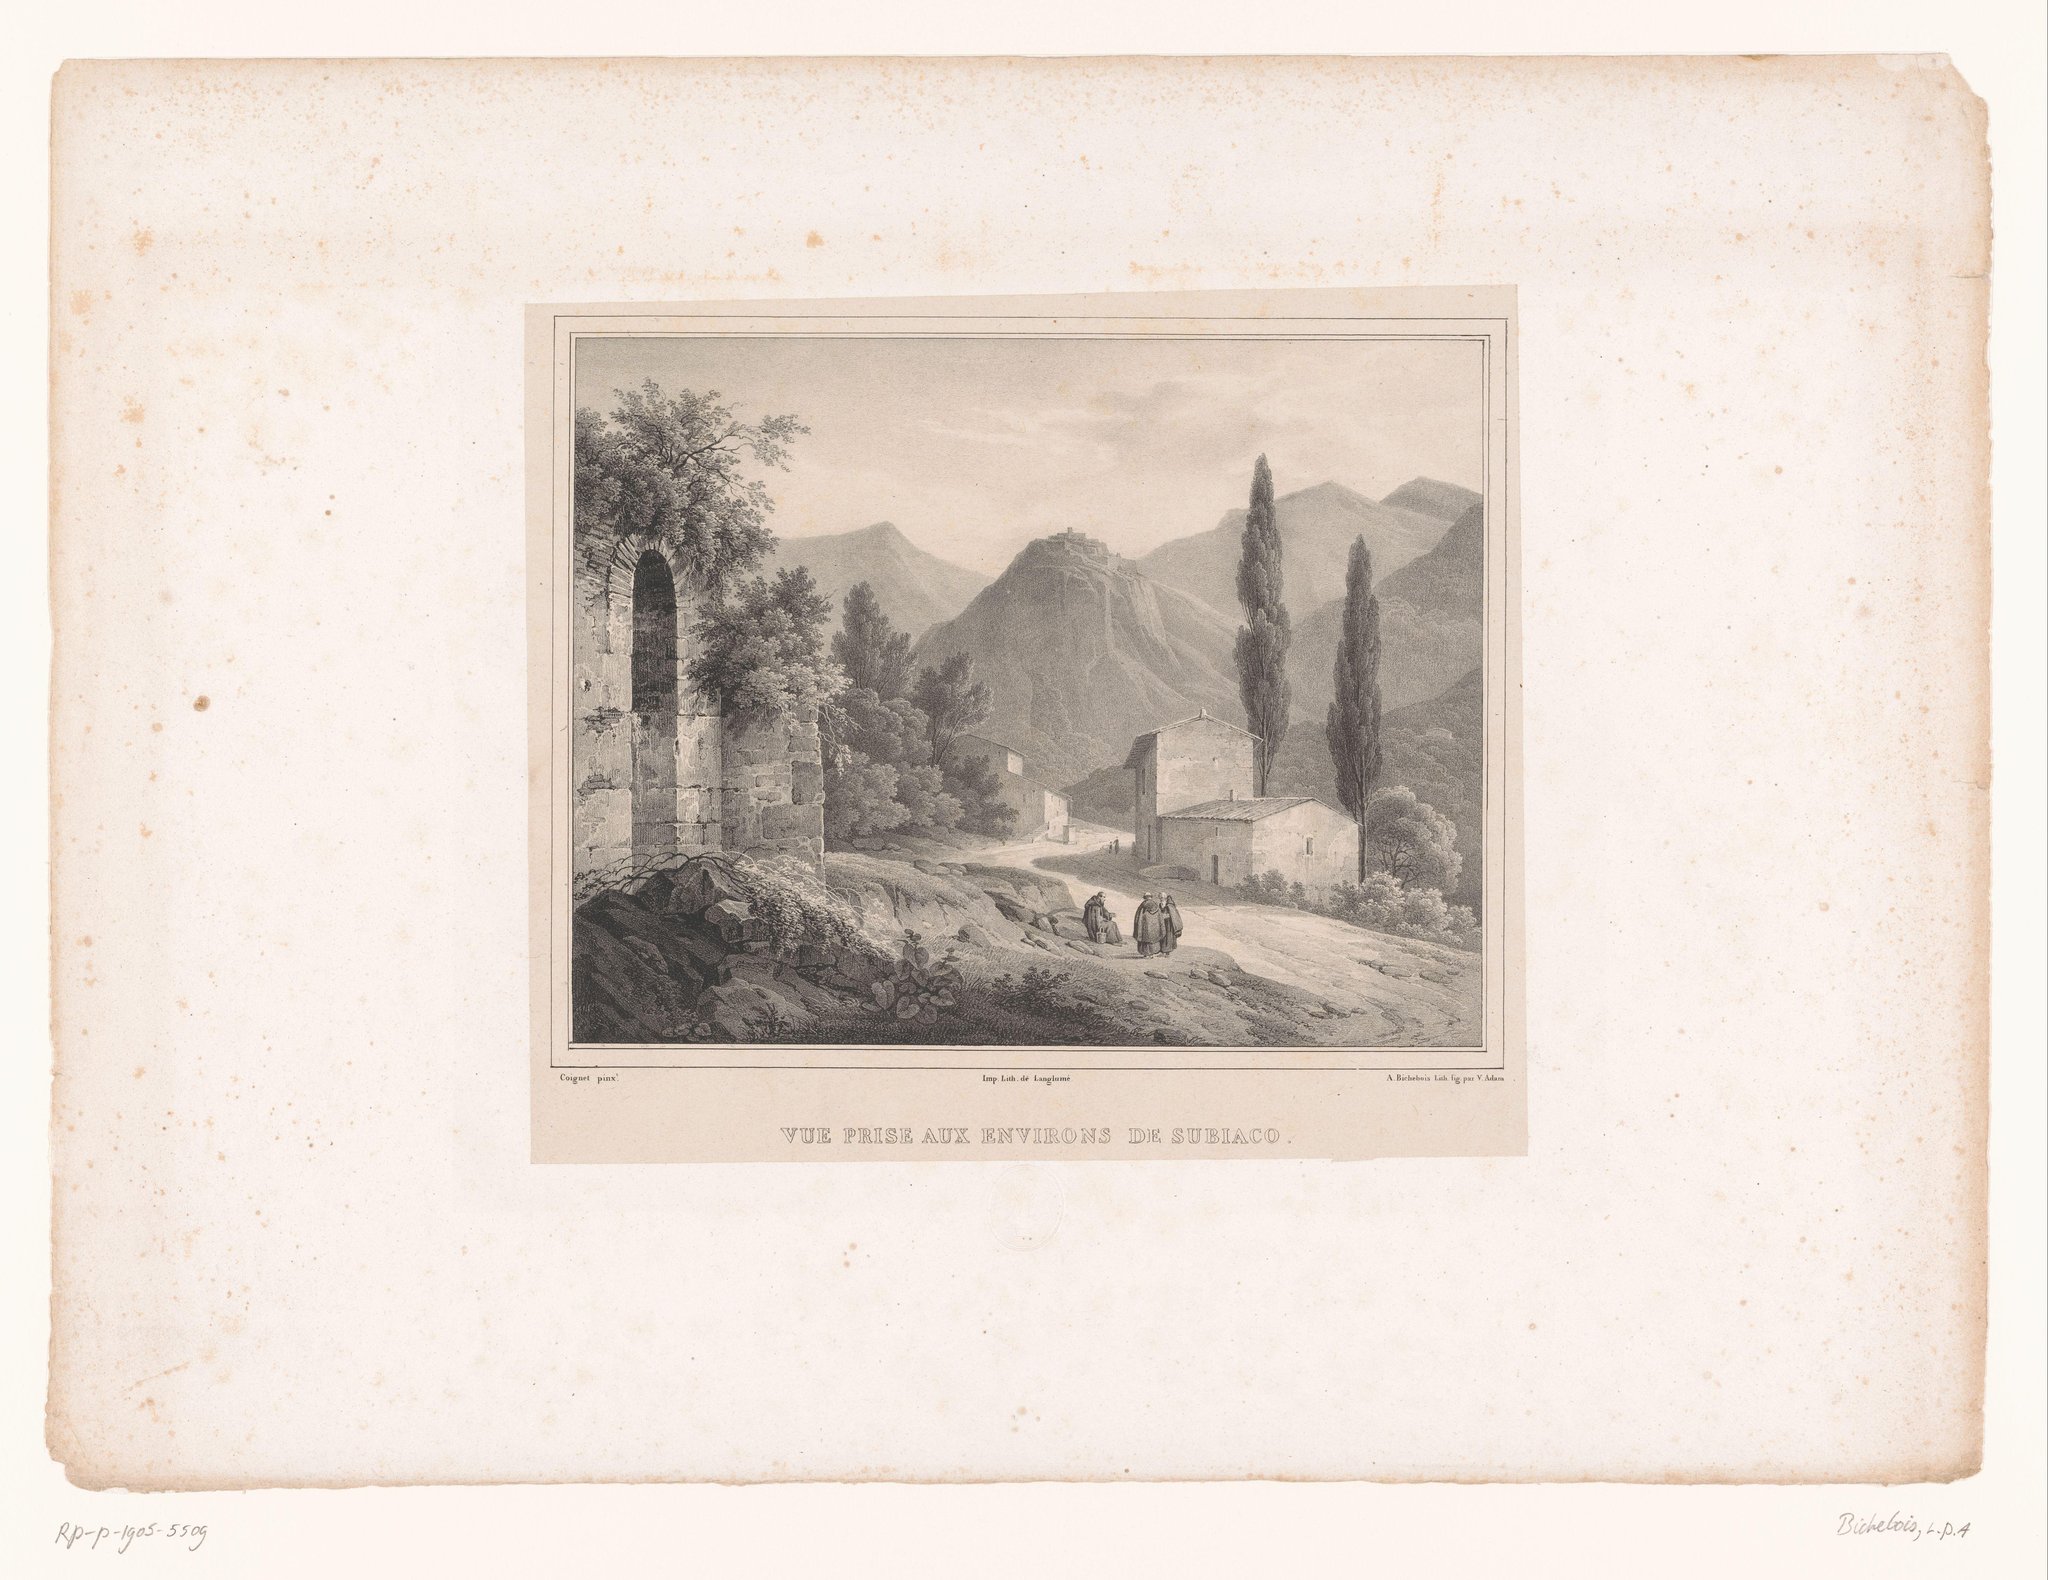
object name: print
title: Zicht op de omgeving van Subiaco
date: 1824-1826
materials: paper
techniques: lithograph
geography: paris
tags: landscape with ruins, mountains (+ landscape with figures, staffage), prospect of village, silhouette of village (+ city(-scape) with figures, staffage)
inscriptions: check stamp: Lugt 3431, collector's mark: Lugt 2228